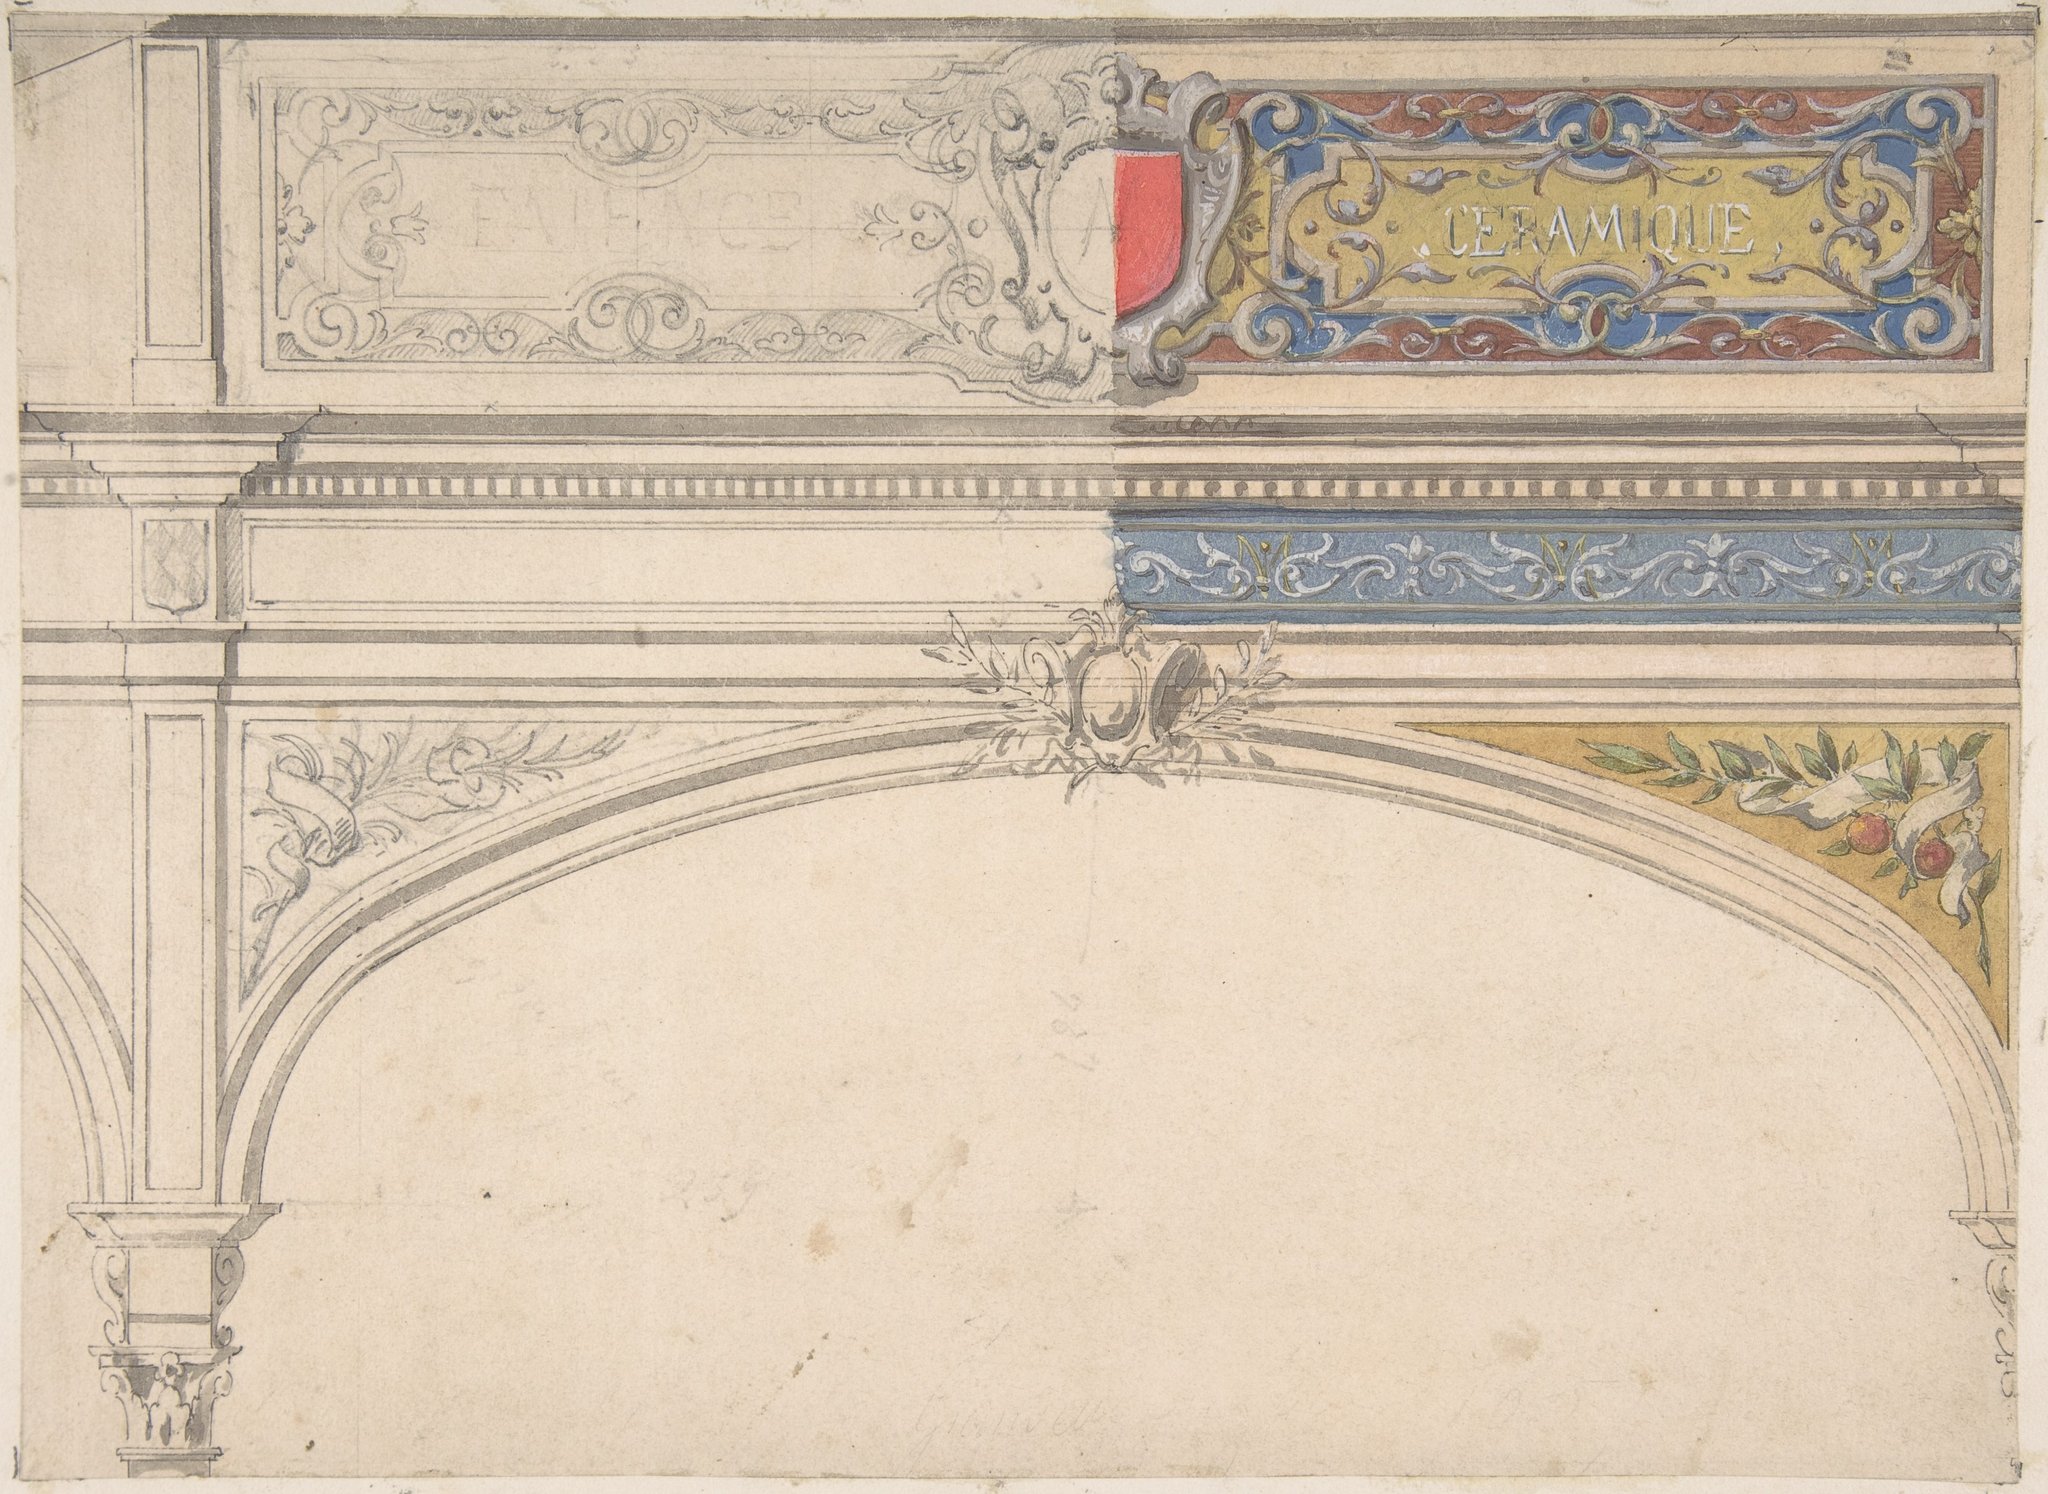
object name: drawing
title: Design for Decorated Archway, Monaco Pavillion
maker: jules-edmond-charles lachaise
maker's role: artist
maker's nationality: french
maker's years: 1897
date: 1878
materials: gouache, graphite, ink, watercolor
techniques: pen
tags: arches